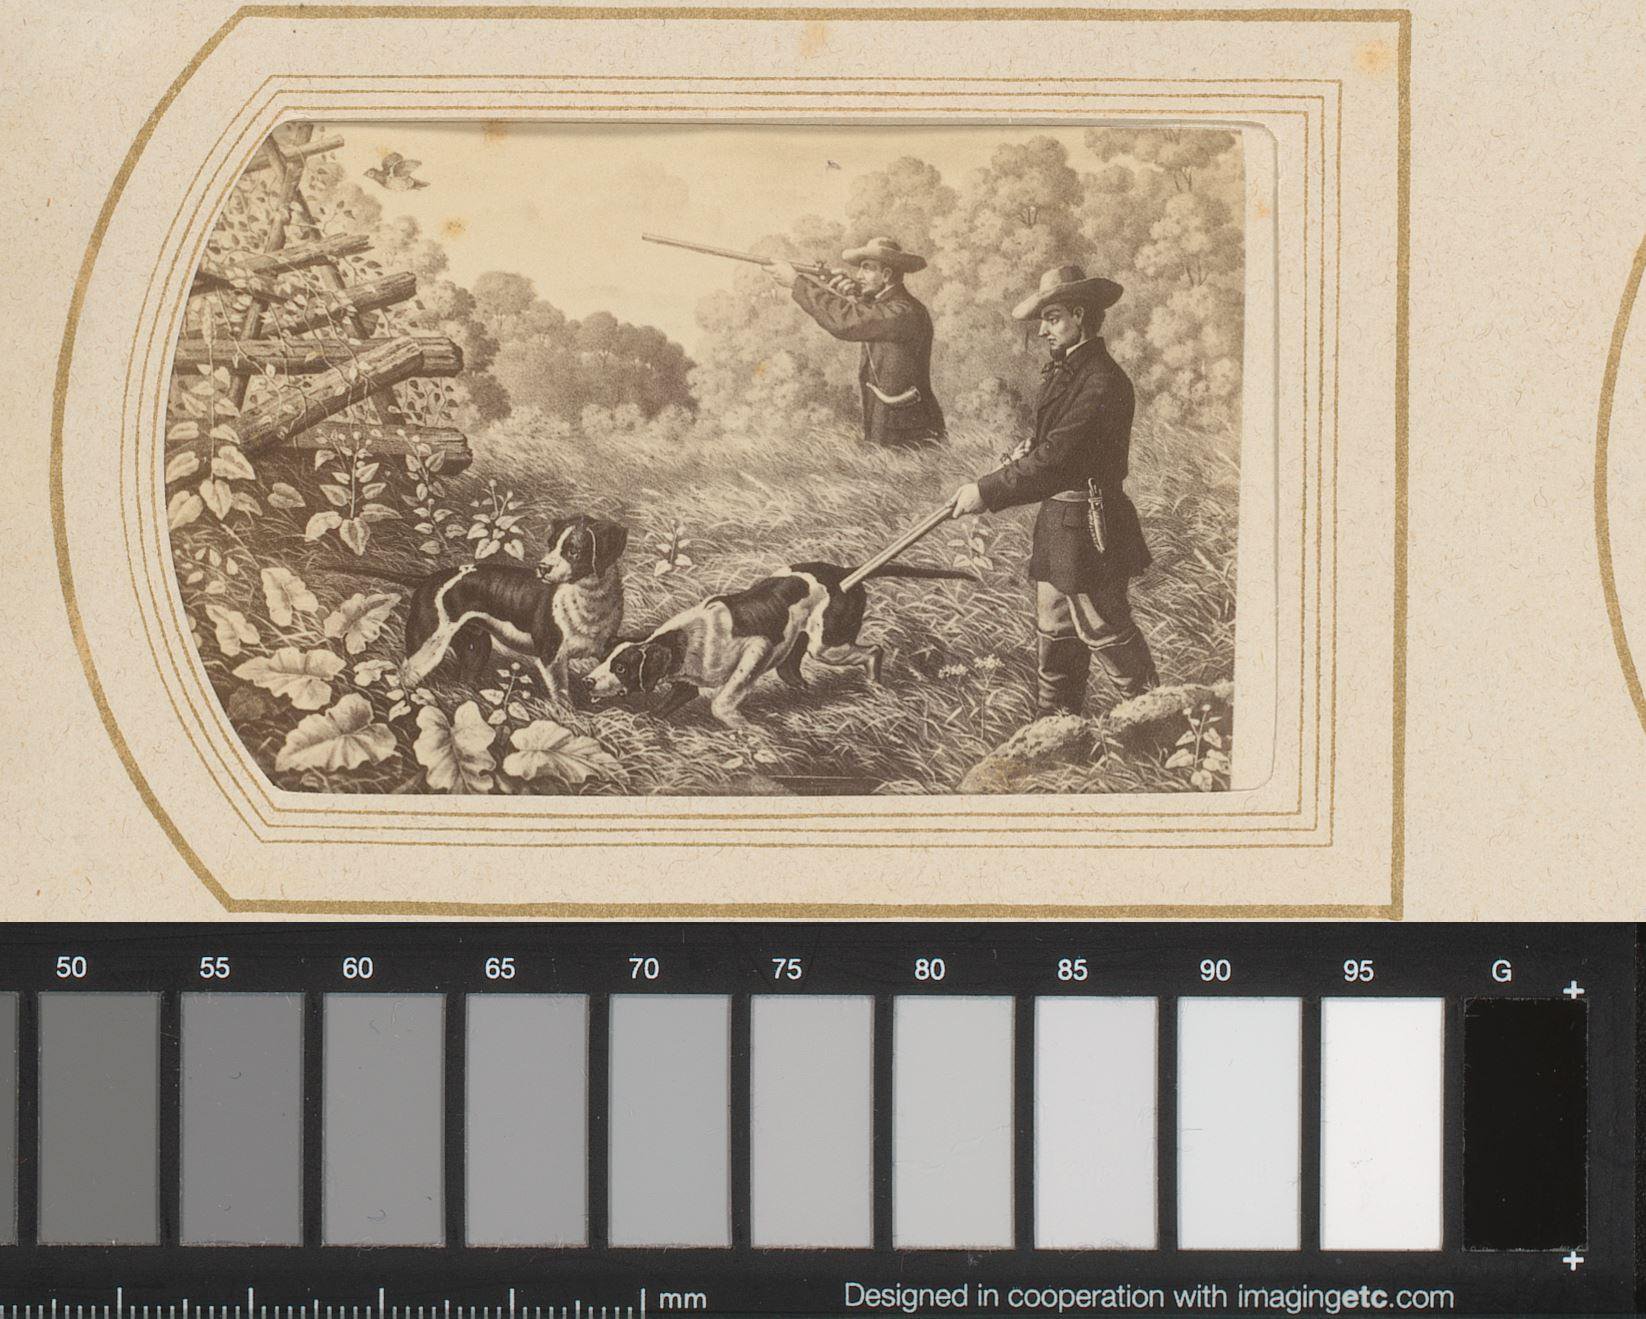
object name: album leaf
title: Fotoreproductie van La chasse au poule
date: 1870-1900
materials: cardboard, photographic support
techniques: albumen print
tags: hunting, chase, dog, painting, drawing and the graphic arts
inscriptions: inscription: ‘Collier/ La chasse au puole/ Hühnerjagd./ Hen.’, annotation: ‘Hühnerjagd’